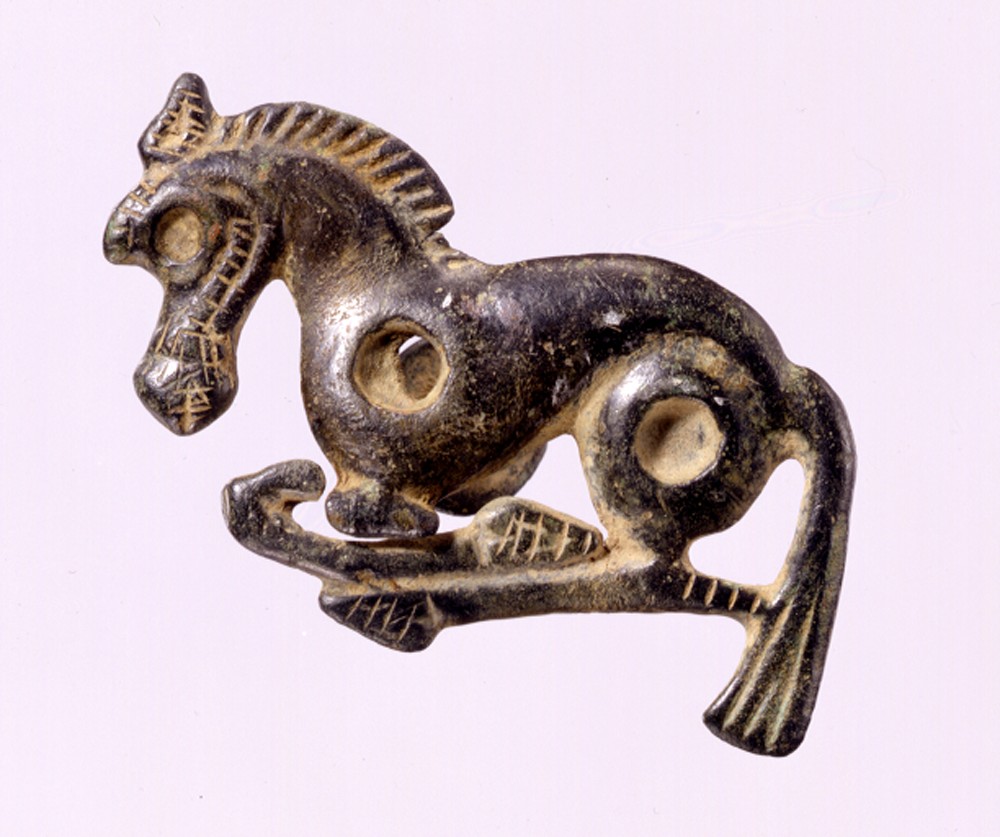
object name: garment plaque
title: Garment Plaque in the Shape of a Przewalski Horse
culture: kazakh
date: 600-301 BCE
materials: bronze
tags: horses